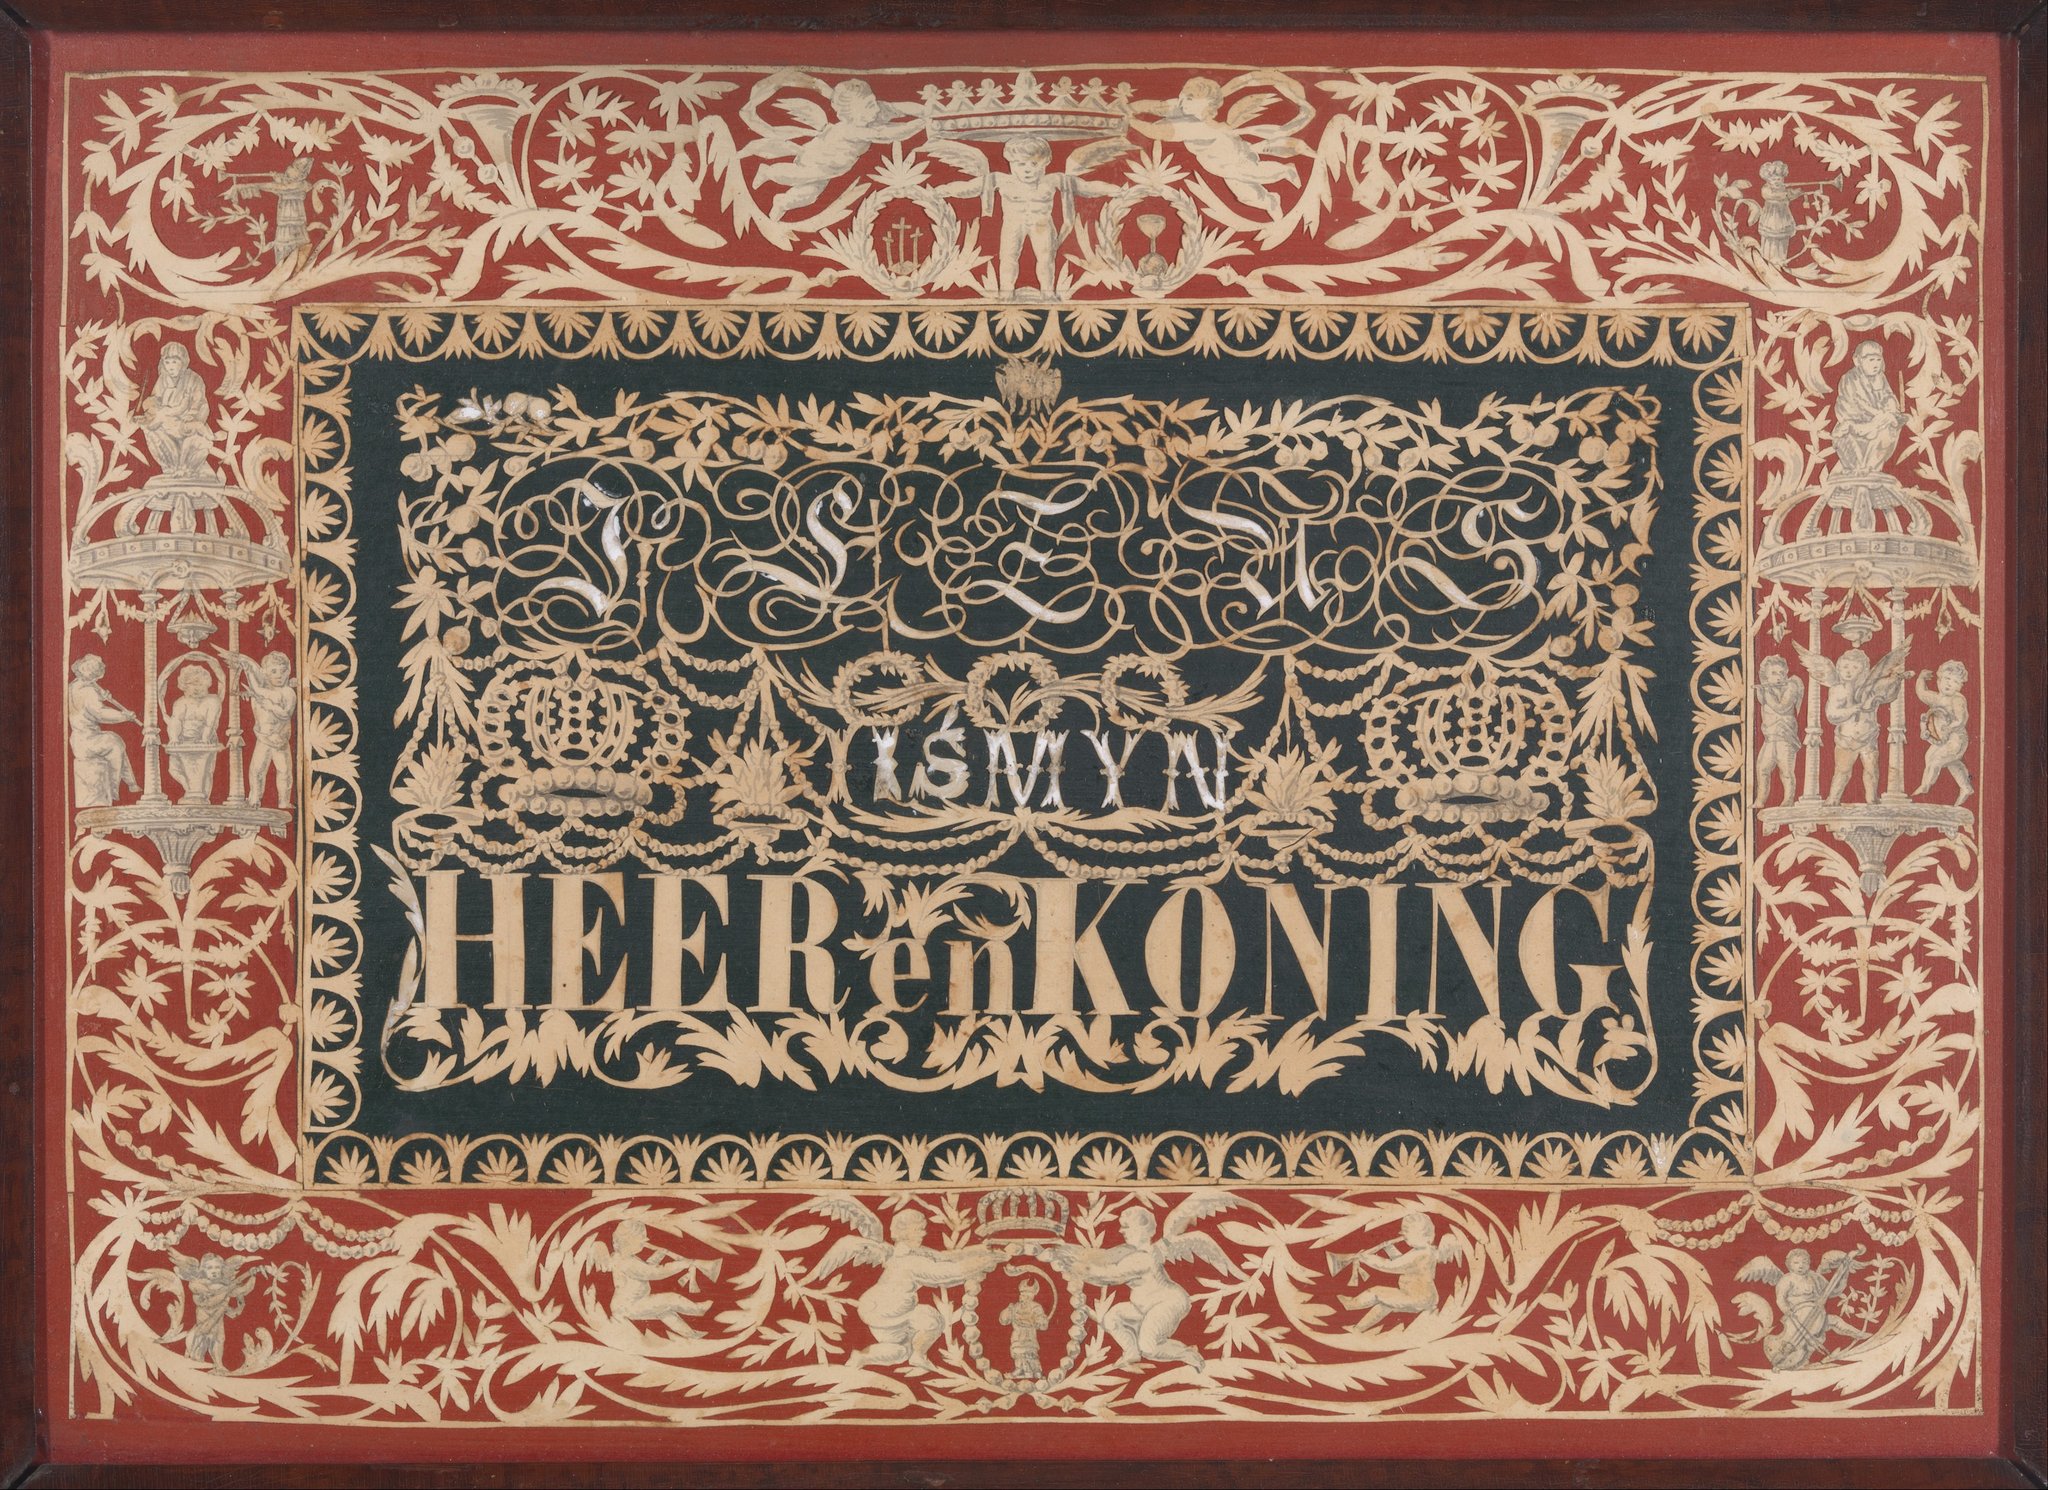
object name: card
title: Greeting Card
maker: anonymous, netherlandish, 19th century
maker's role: artist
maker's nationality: netherlandish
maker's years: 1800-1900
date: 1850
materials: paper, pencil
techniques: cutting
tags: leaves,angels,coat of arms